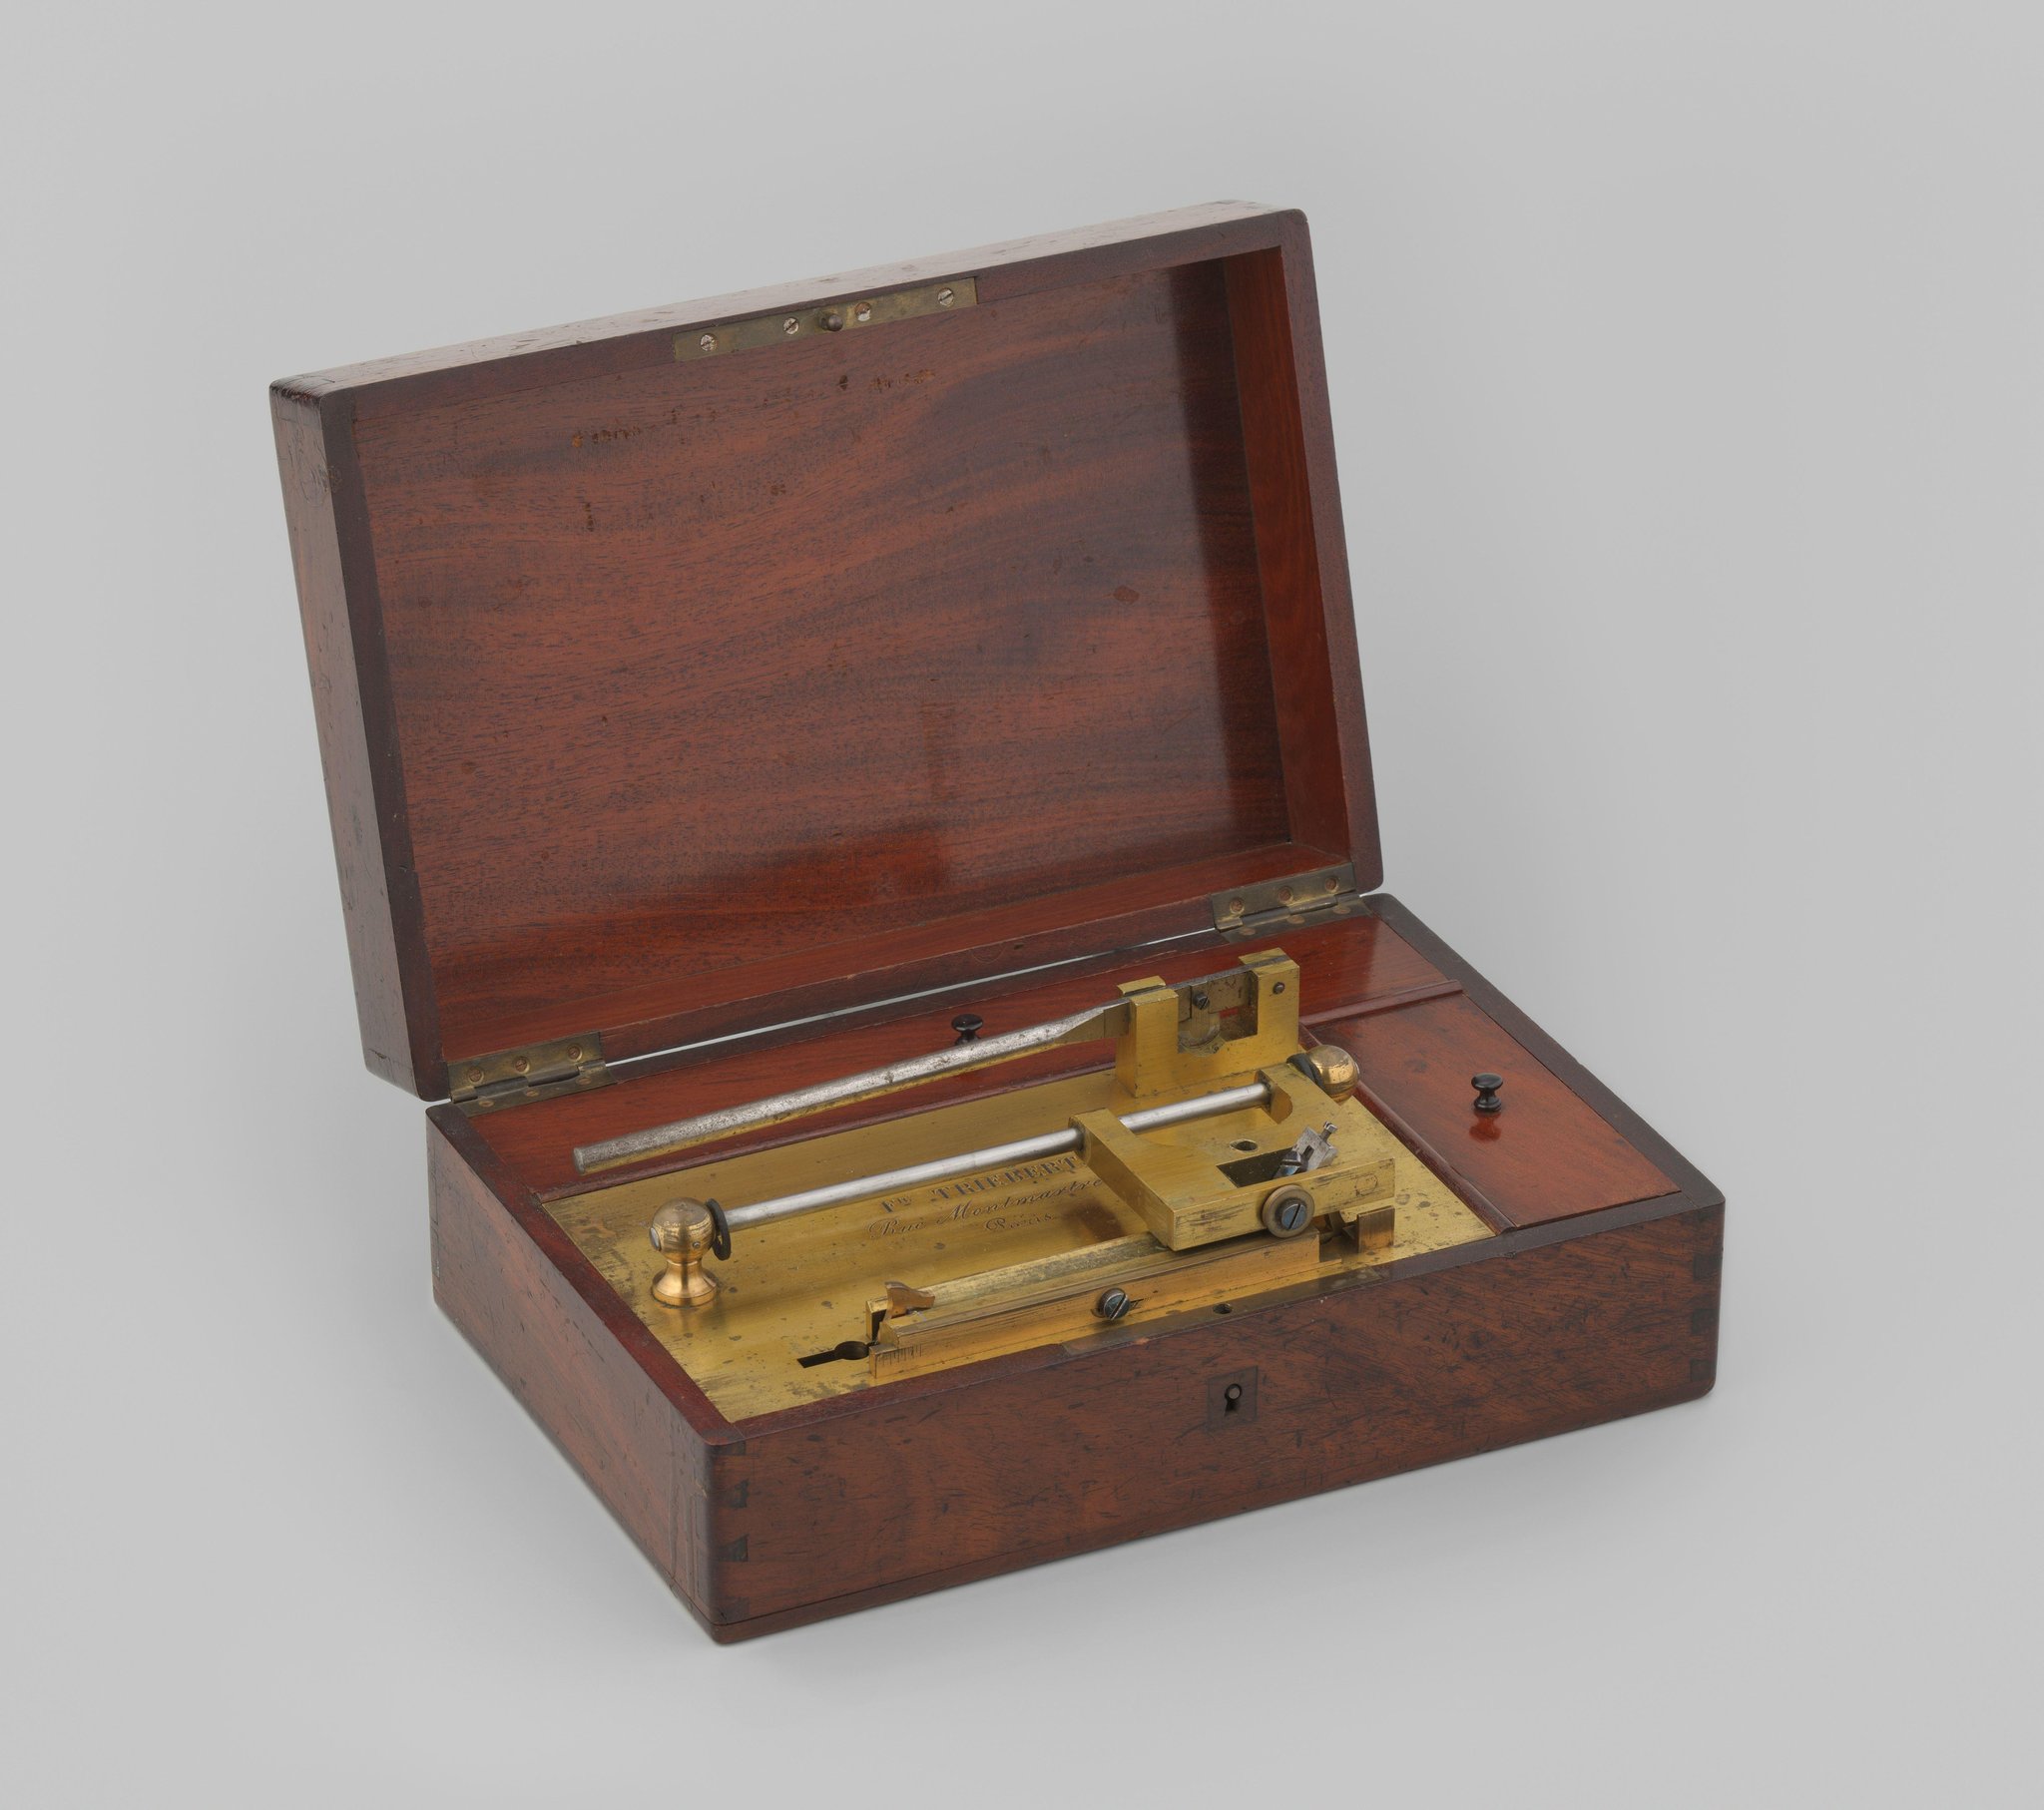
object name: wind instrument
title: Reed Gouging Machine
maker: guillaume triébert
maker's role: musical instrument maker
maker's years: 1770-1848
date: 1840-1850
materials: brass, iron, wood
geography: paris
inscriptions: inscription: ‘Fic TRIEBERT / Rue Monmartre 132, / Paris.’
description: Reed-making Equipment. The sound of the oboe is produced by blowing air through the reed, which is fixed at the upper end of the instrument. It consists of a slip of Arundo donax (cane) folded in half, with a small opening at the tip. The wood is scraped thinly so that it will vibrate when blown through. Players must make their own reeds, which they learn how to do during their training. In the 19th century, French oboe makers designed various tools to simplify the reedmaking process.